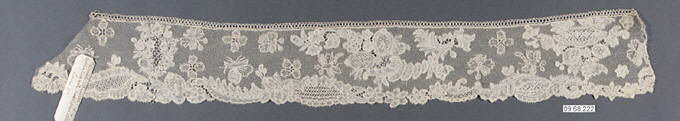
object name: fragment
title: Fragment of lace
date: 1701-1800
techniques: lace